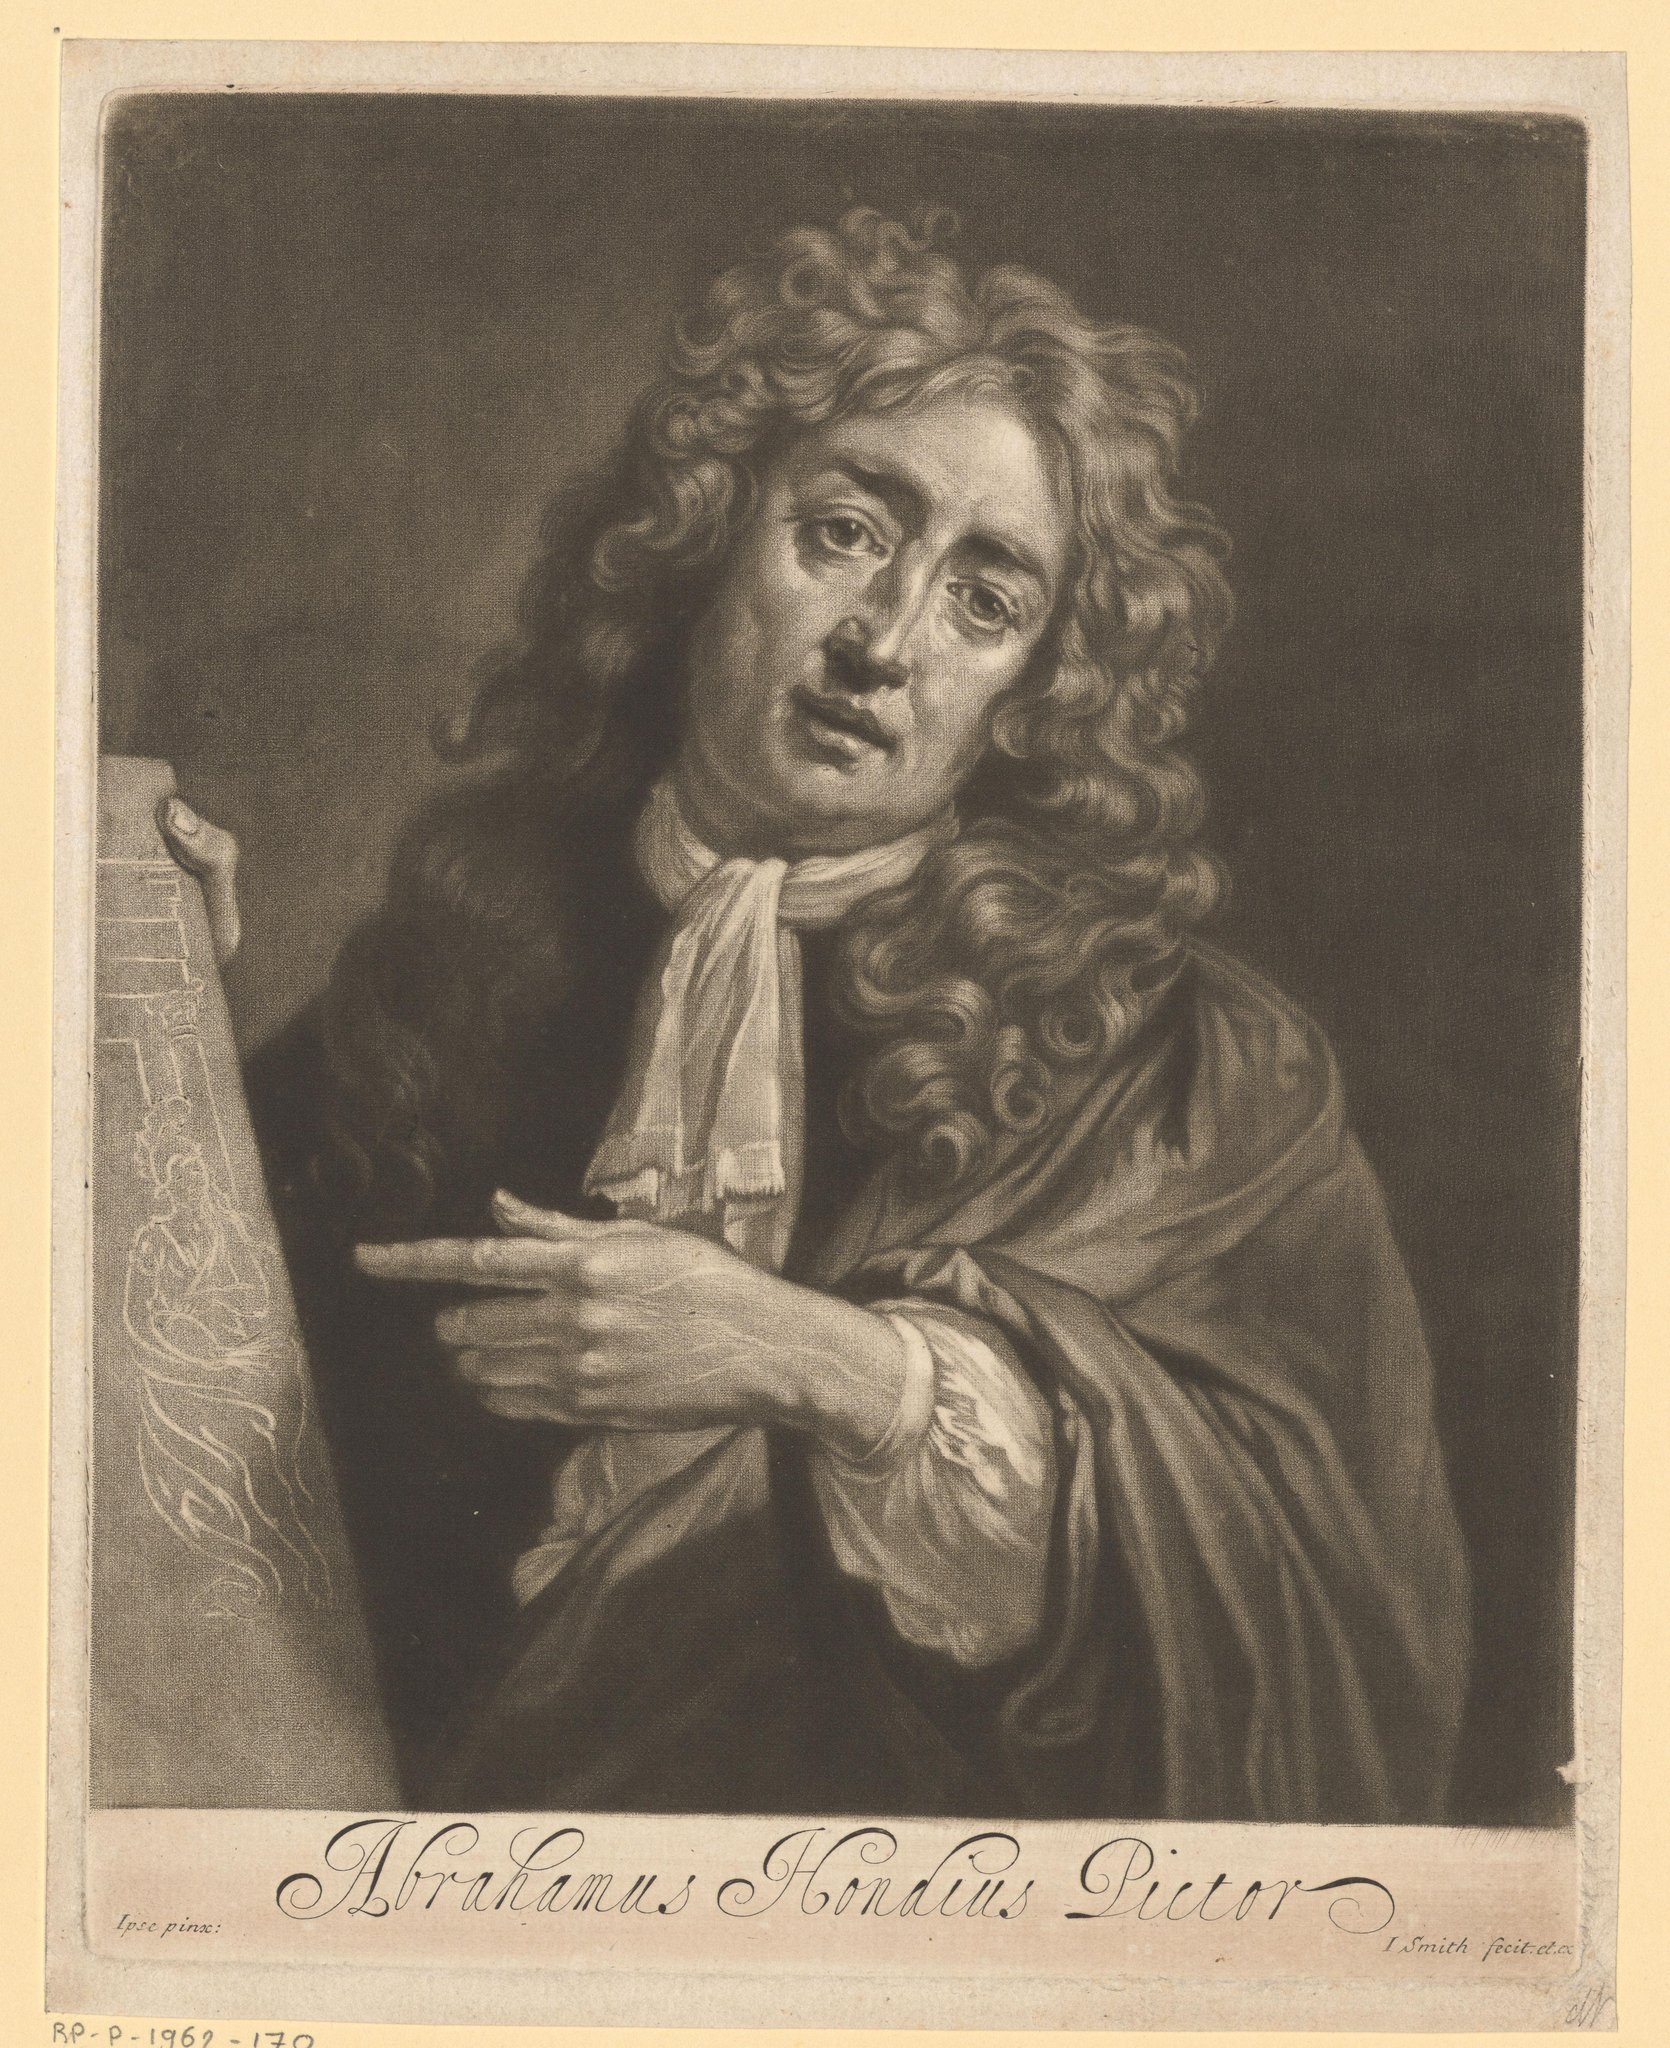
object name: print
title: Portret van Abraham Daniëlsz. Hondius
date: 1675-1743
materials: paper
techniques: engraving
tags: rotterdam, london, painter, print maker, abraham daniëlsz. hondius, historical persons, portrait, self-portrait of painter